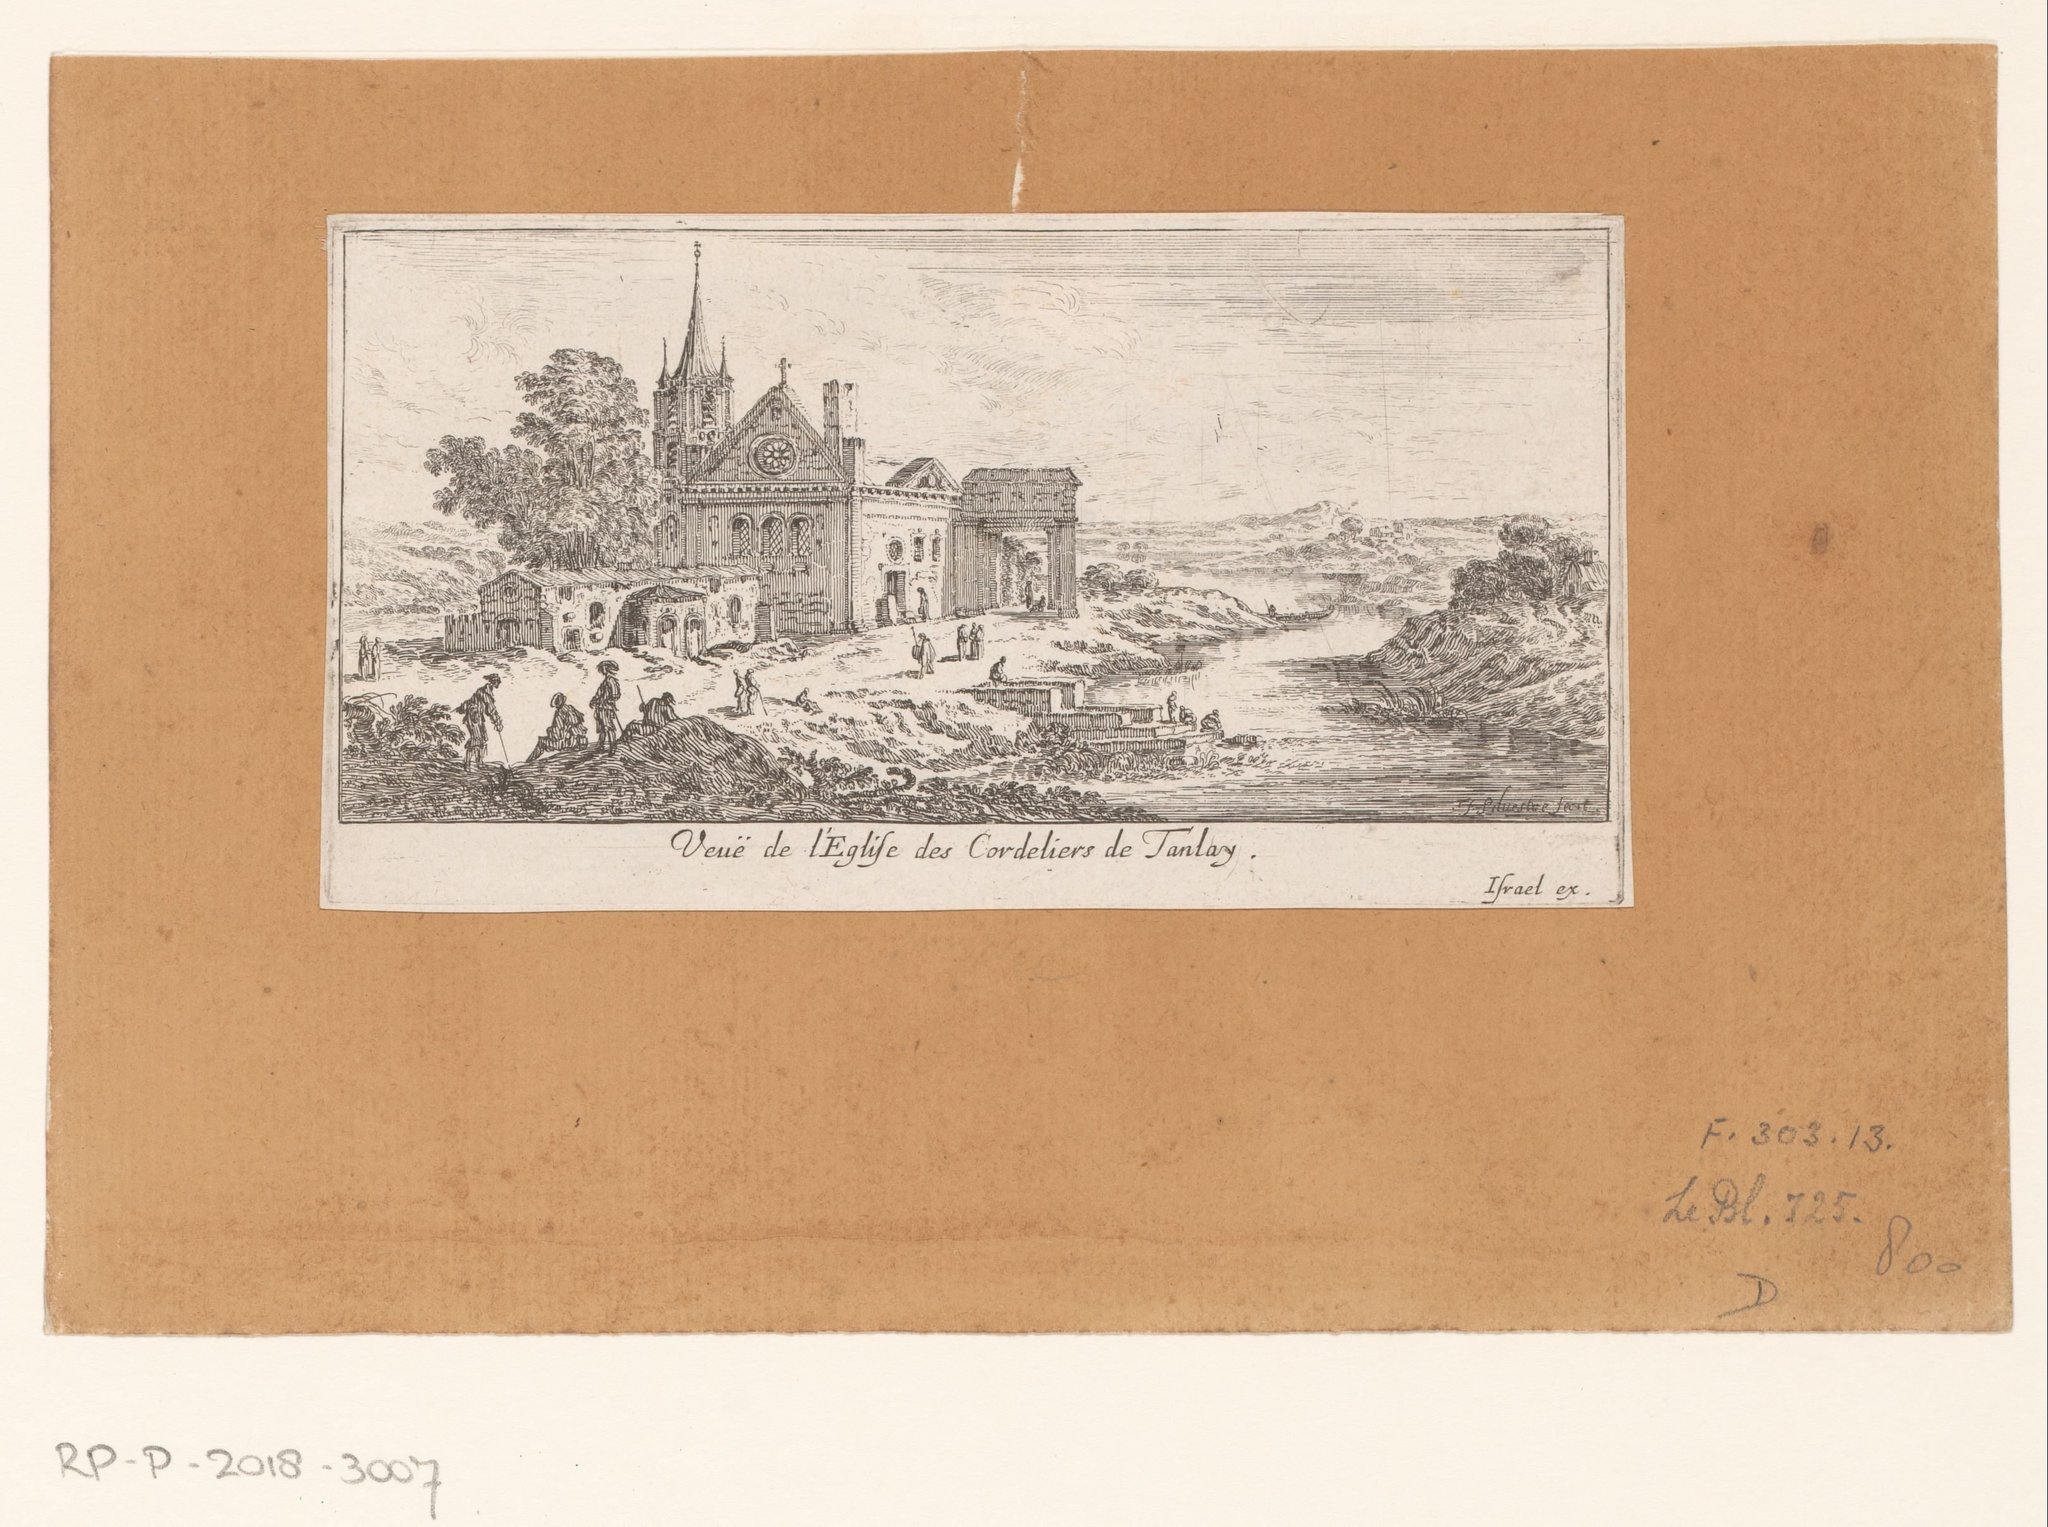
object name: print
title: Gezicht op de Minorietenkerk te Tanlay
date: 1631-1691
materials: paper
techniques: etching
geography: paris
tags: church (exterior), monastic orders, monastic life ~ roman catholic church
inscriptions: collector's mark: Lugt 2228